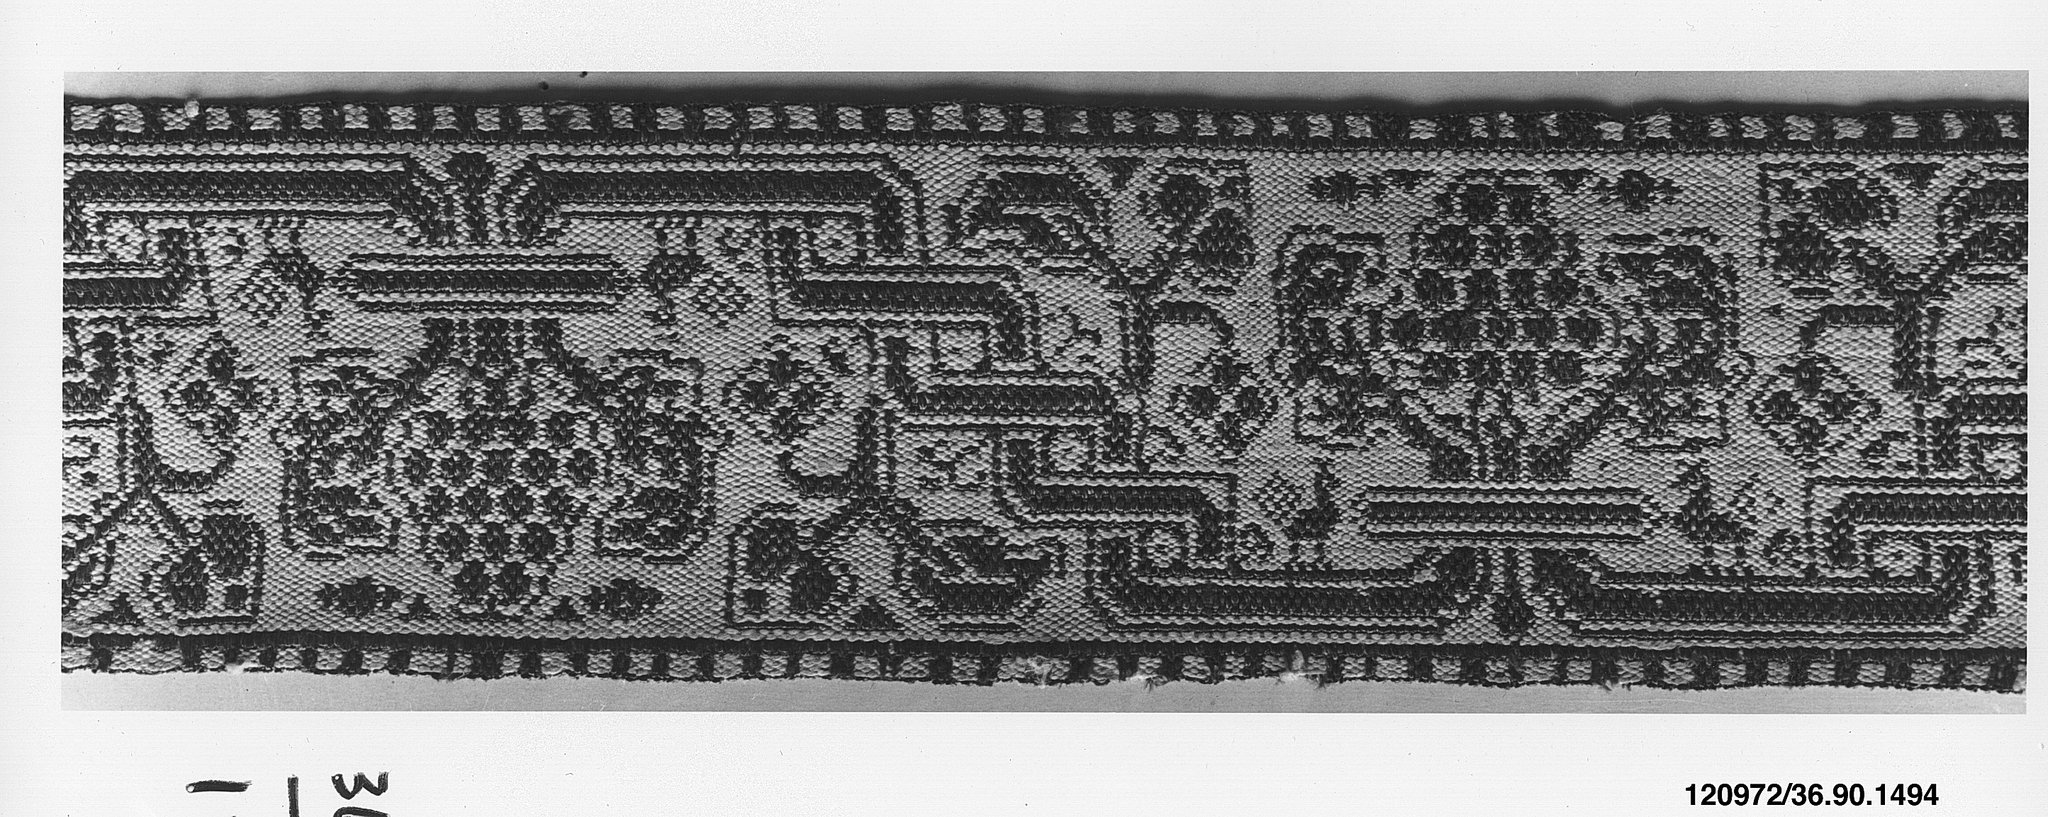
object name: piece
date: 1501-1700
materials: cotton, silk